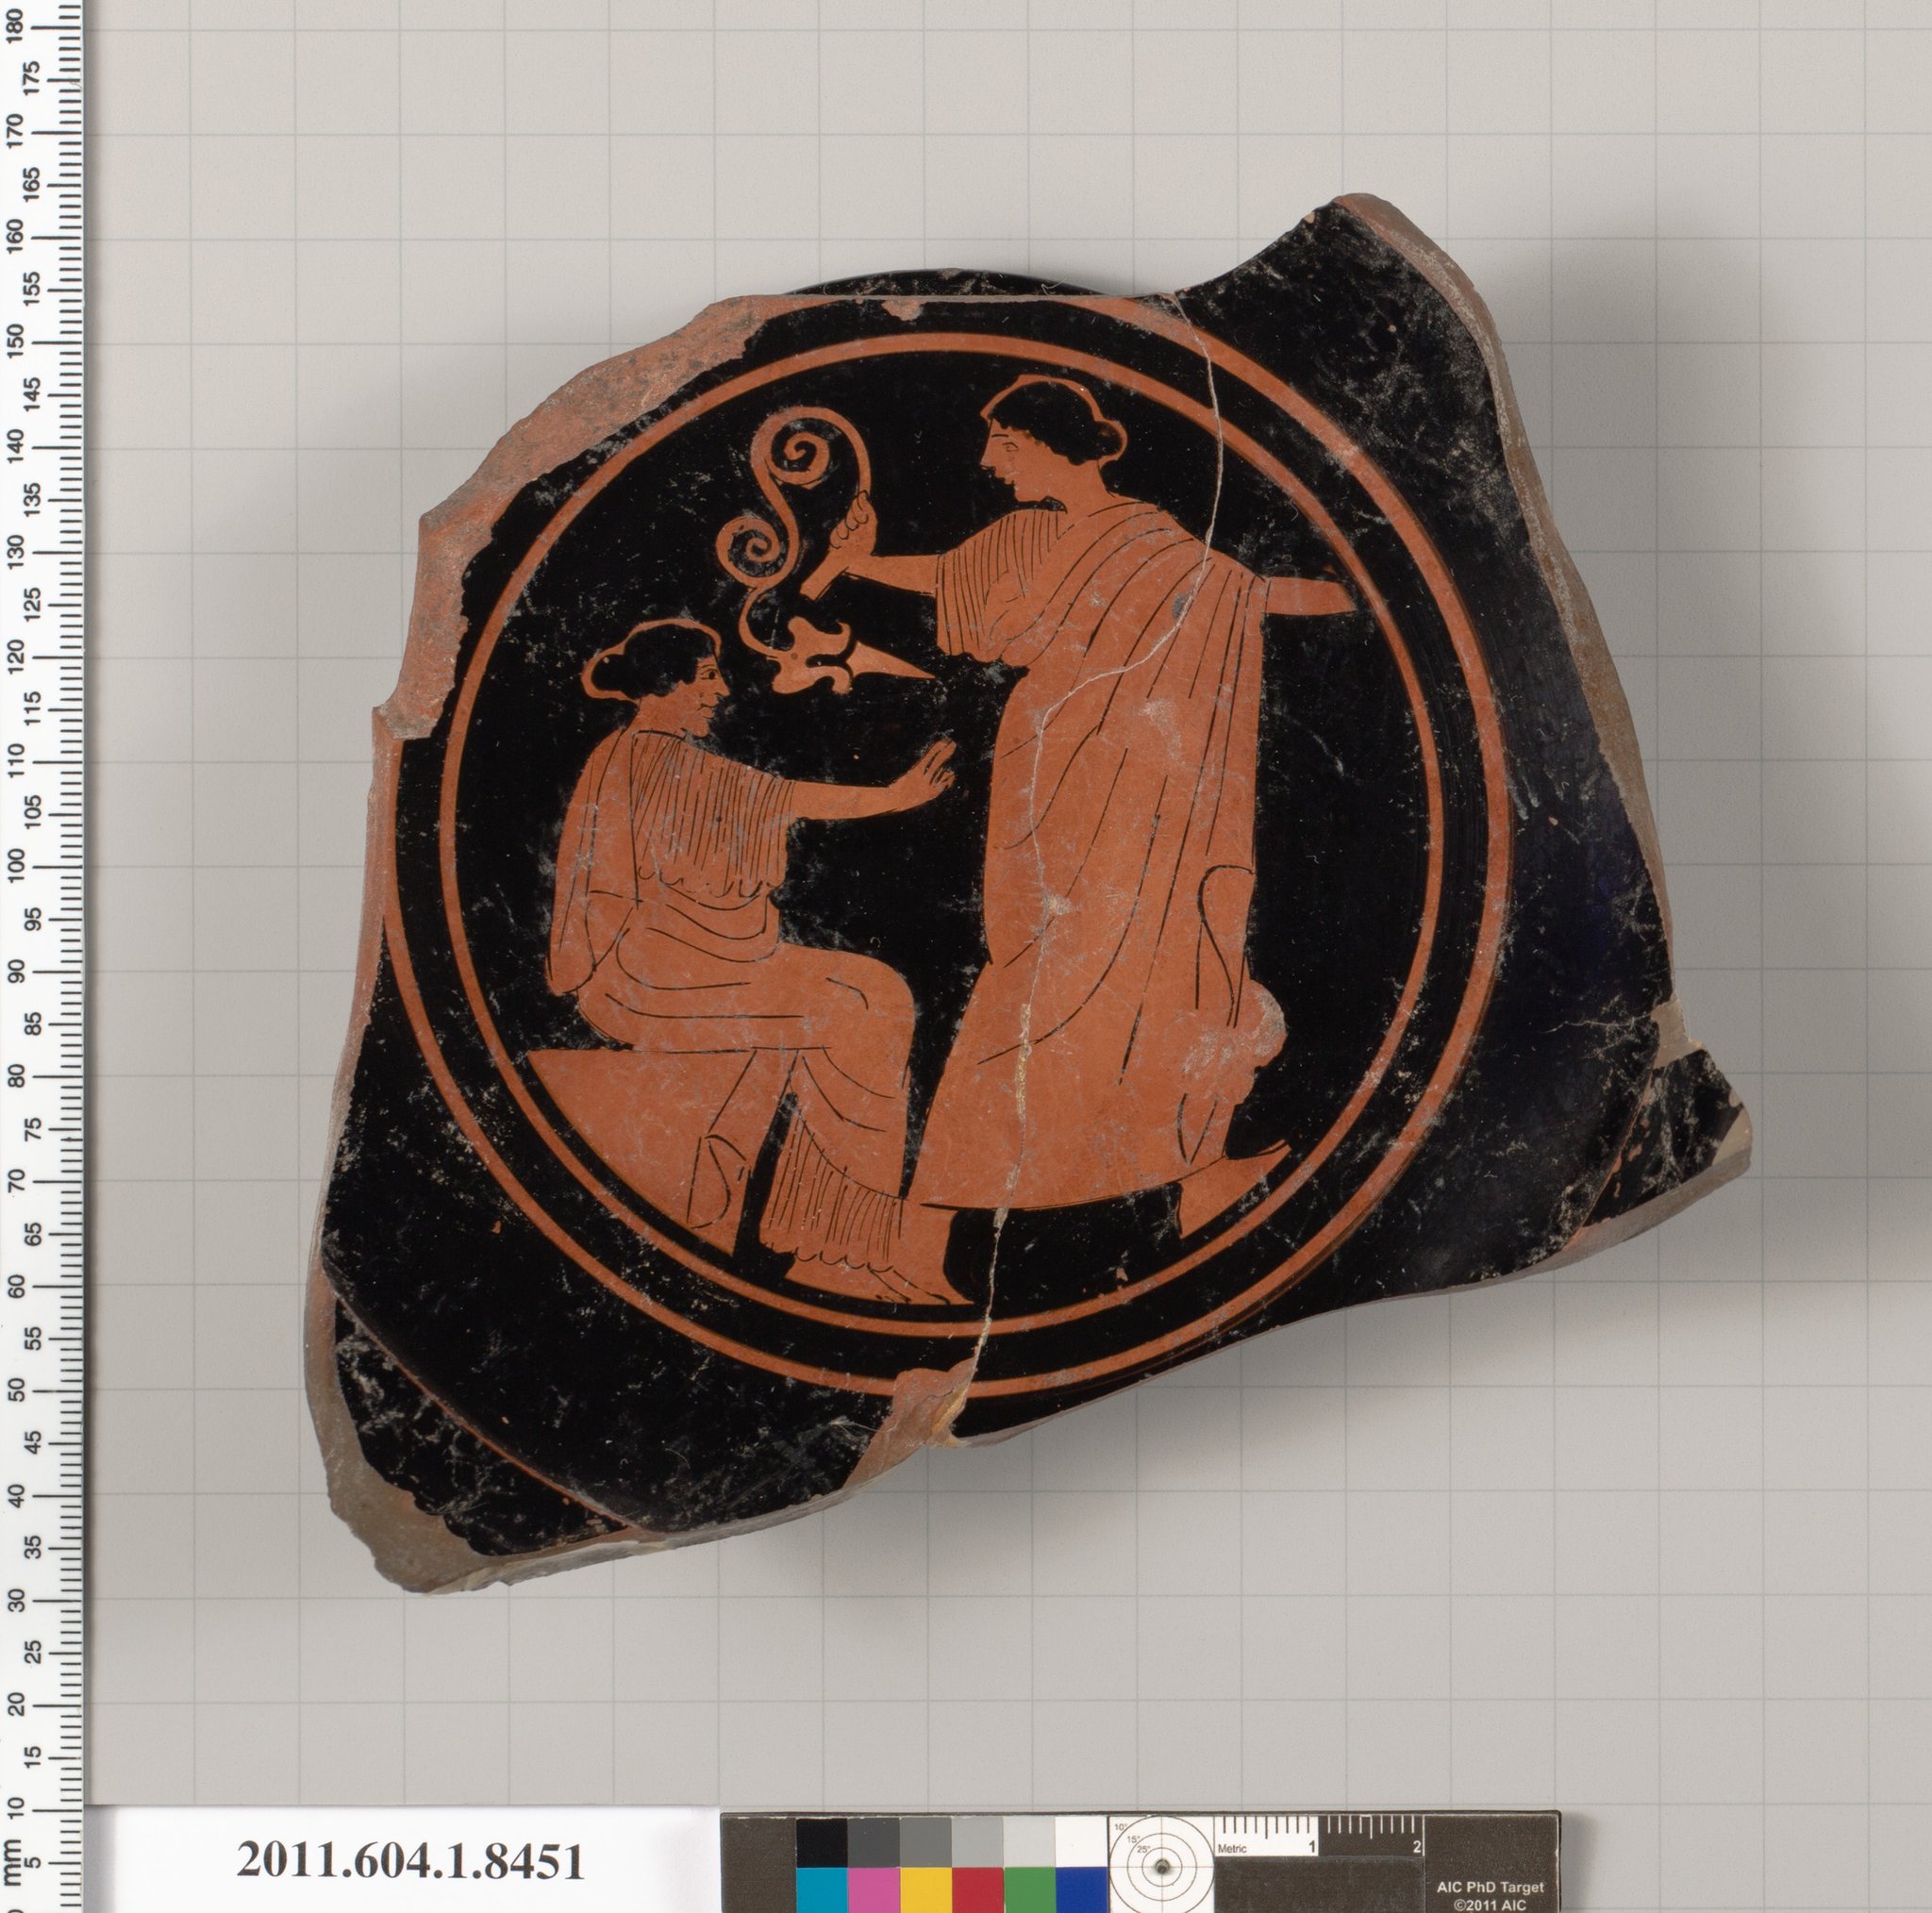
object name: kylix fragment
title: Terracotta fragment of a stemless kylix (drinking cup)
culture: greek, attic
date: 460-450 BCE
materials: terracotta